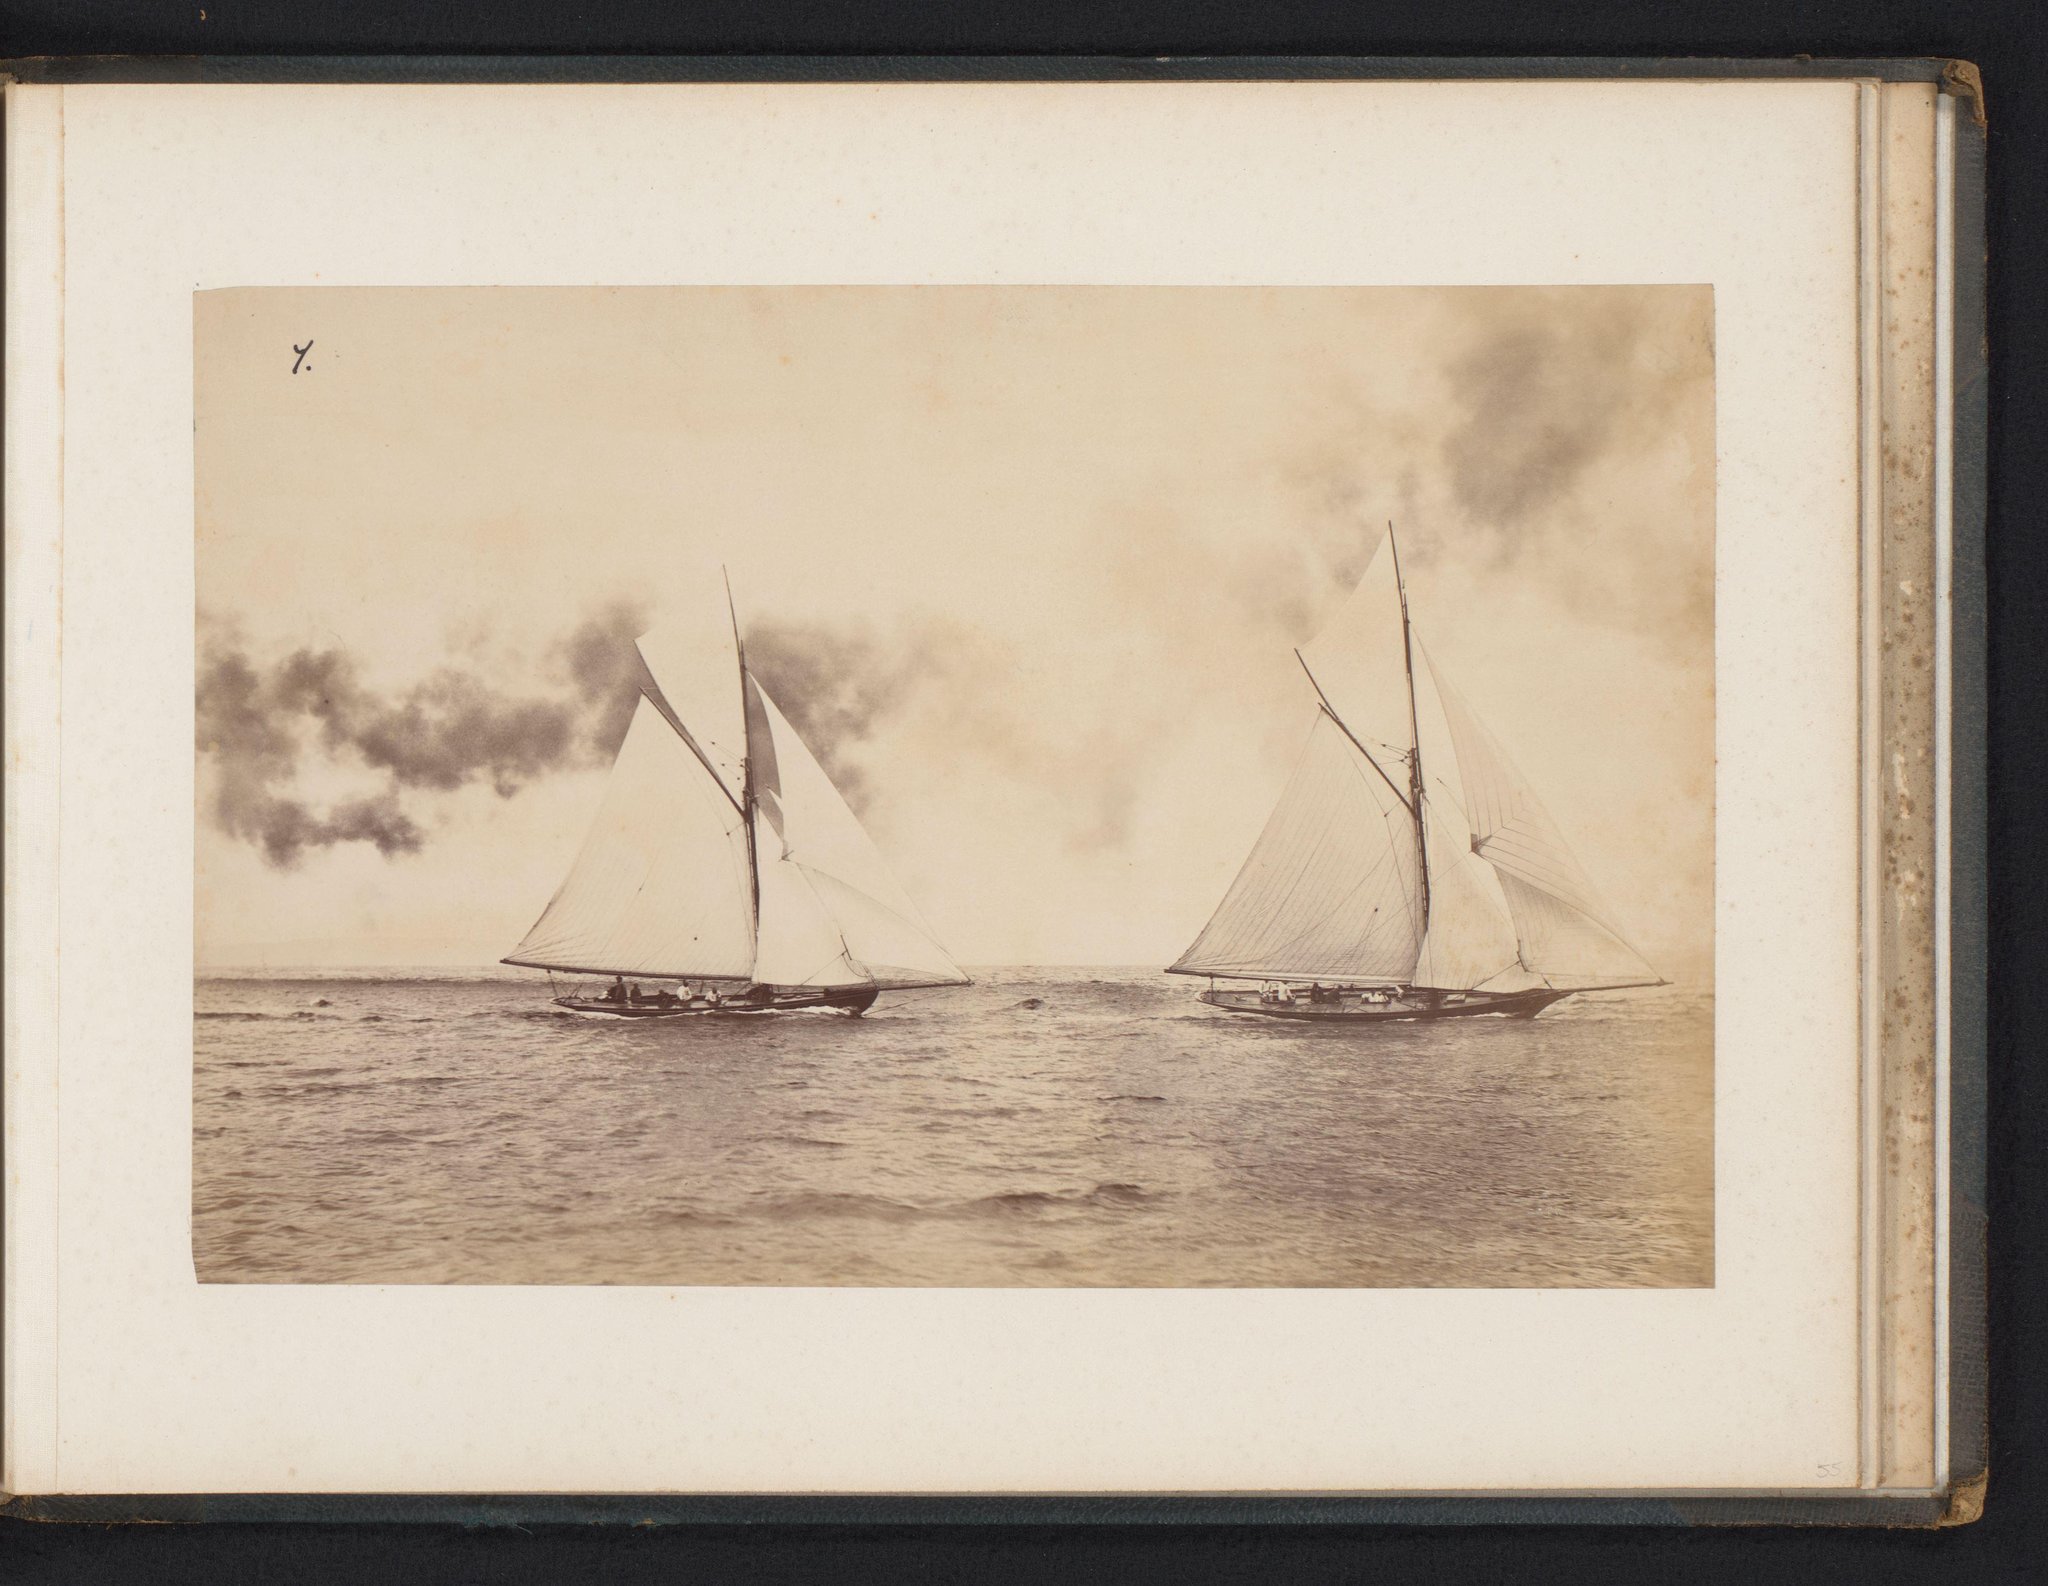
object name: album leaf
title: Zeilschepen de Dora en Yvonne te water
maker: james adamson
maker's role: fotograaf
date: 1880-1900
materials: photographic support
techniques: albumen print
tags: sailing-ship, sailing-boat, landscapes with waters, waterscapes, seascapes (in the temperate zone)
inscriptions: number: ‘7’, check stamp: ‘Adamson, Rothesay.H.B/ Copyright’